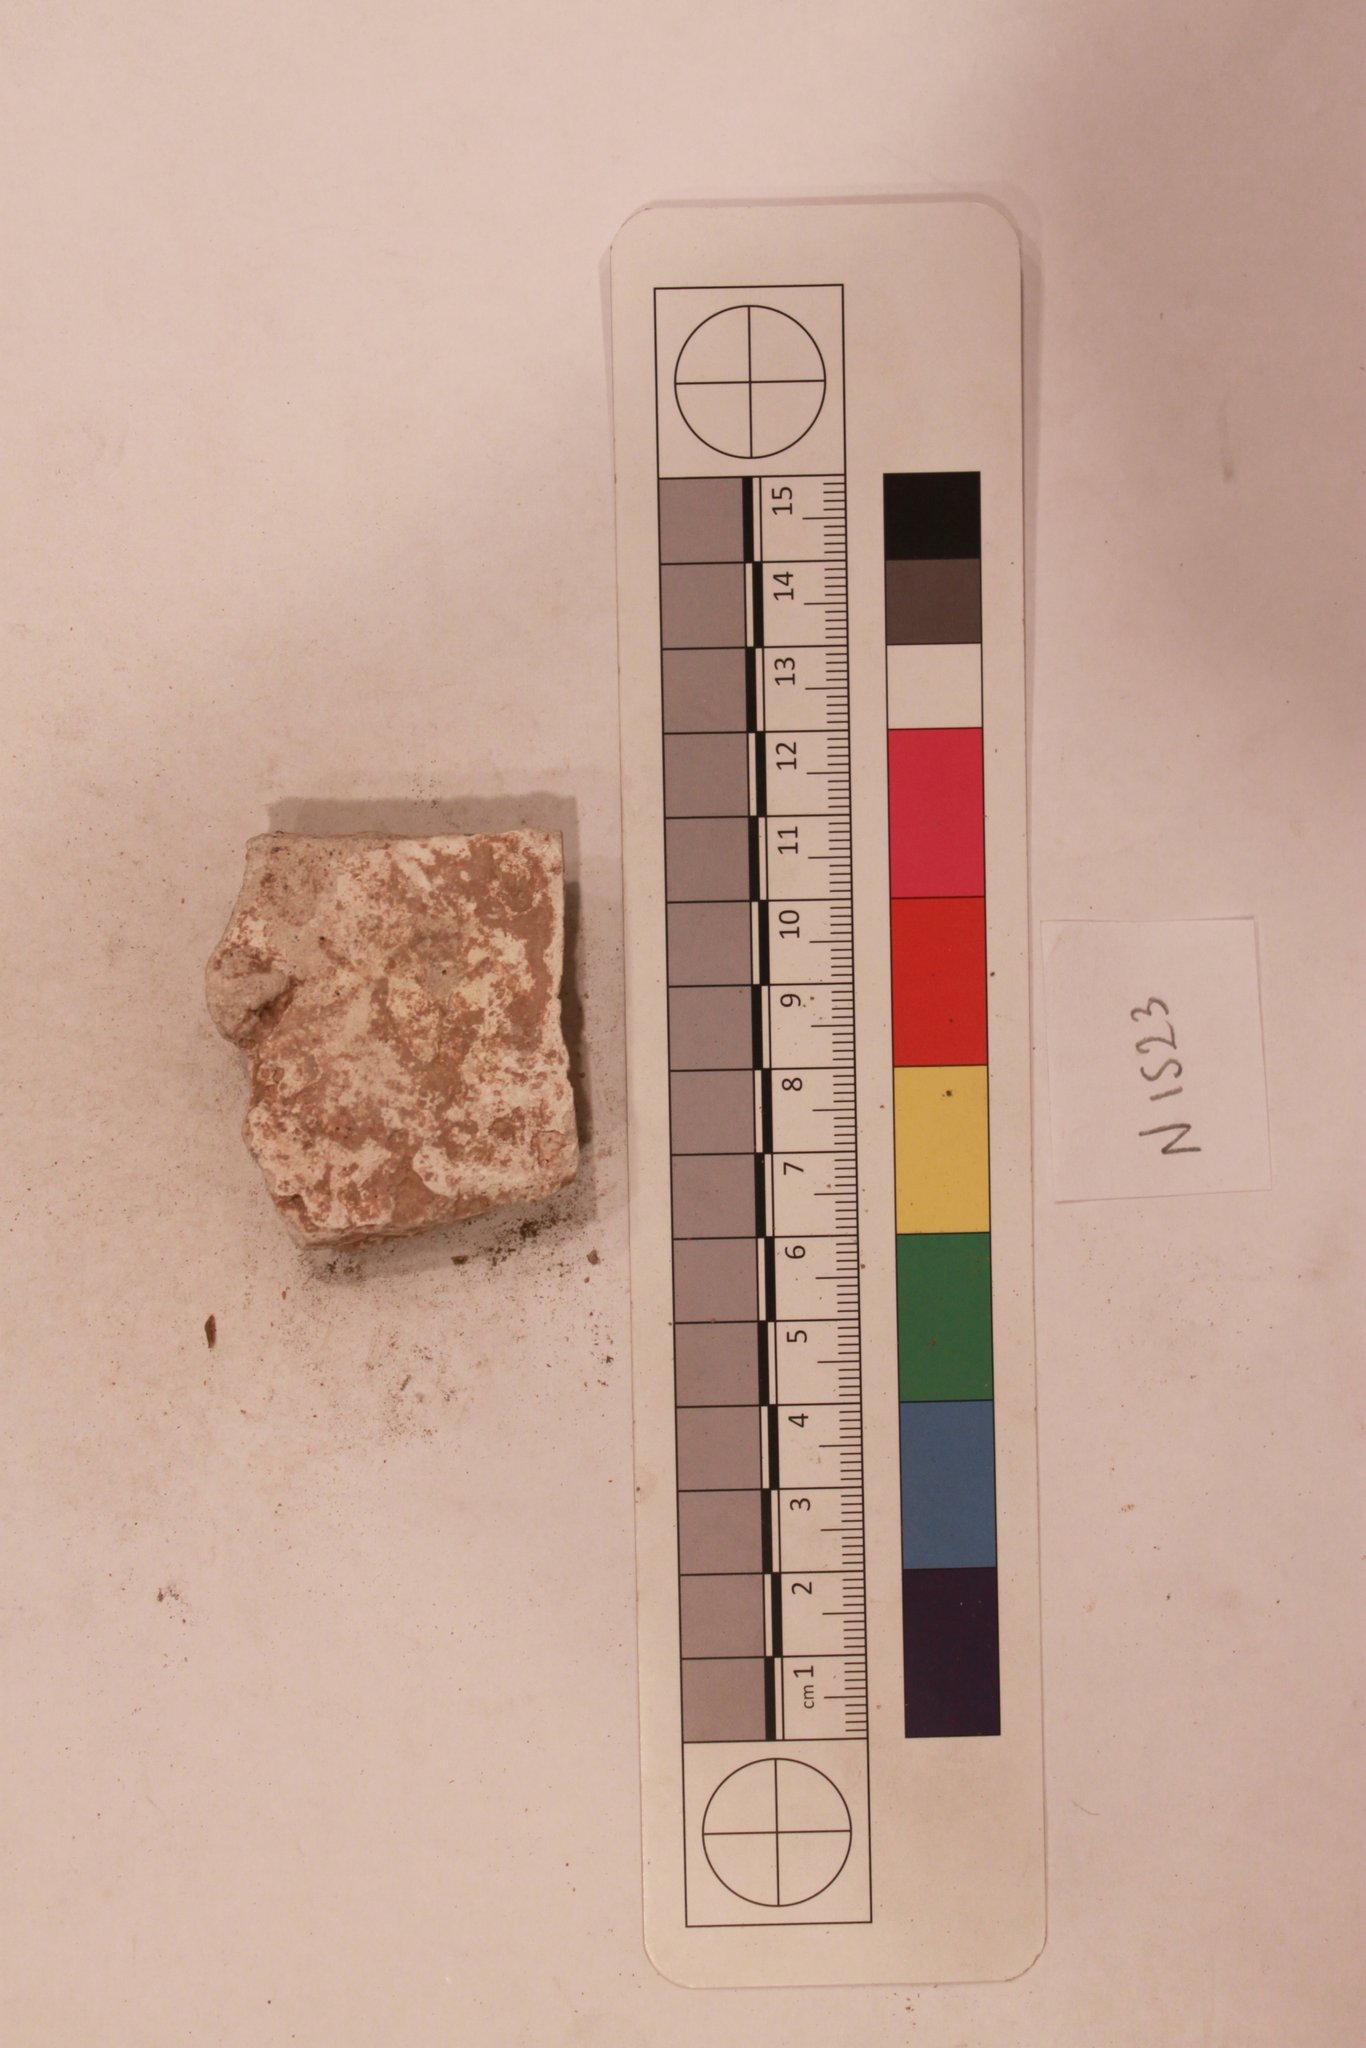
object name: fragment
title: Stucco Fragment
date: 701-1200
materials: plaster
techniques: carving, painting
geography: iran